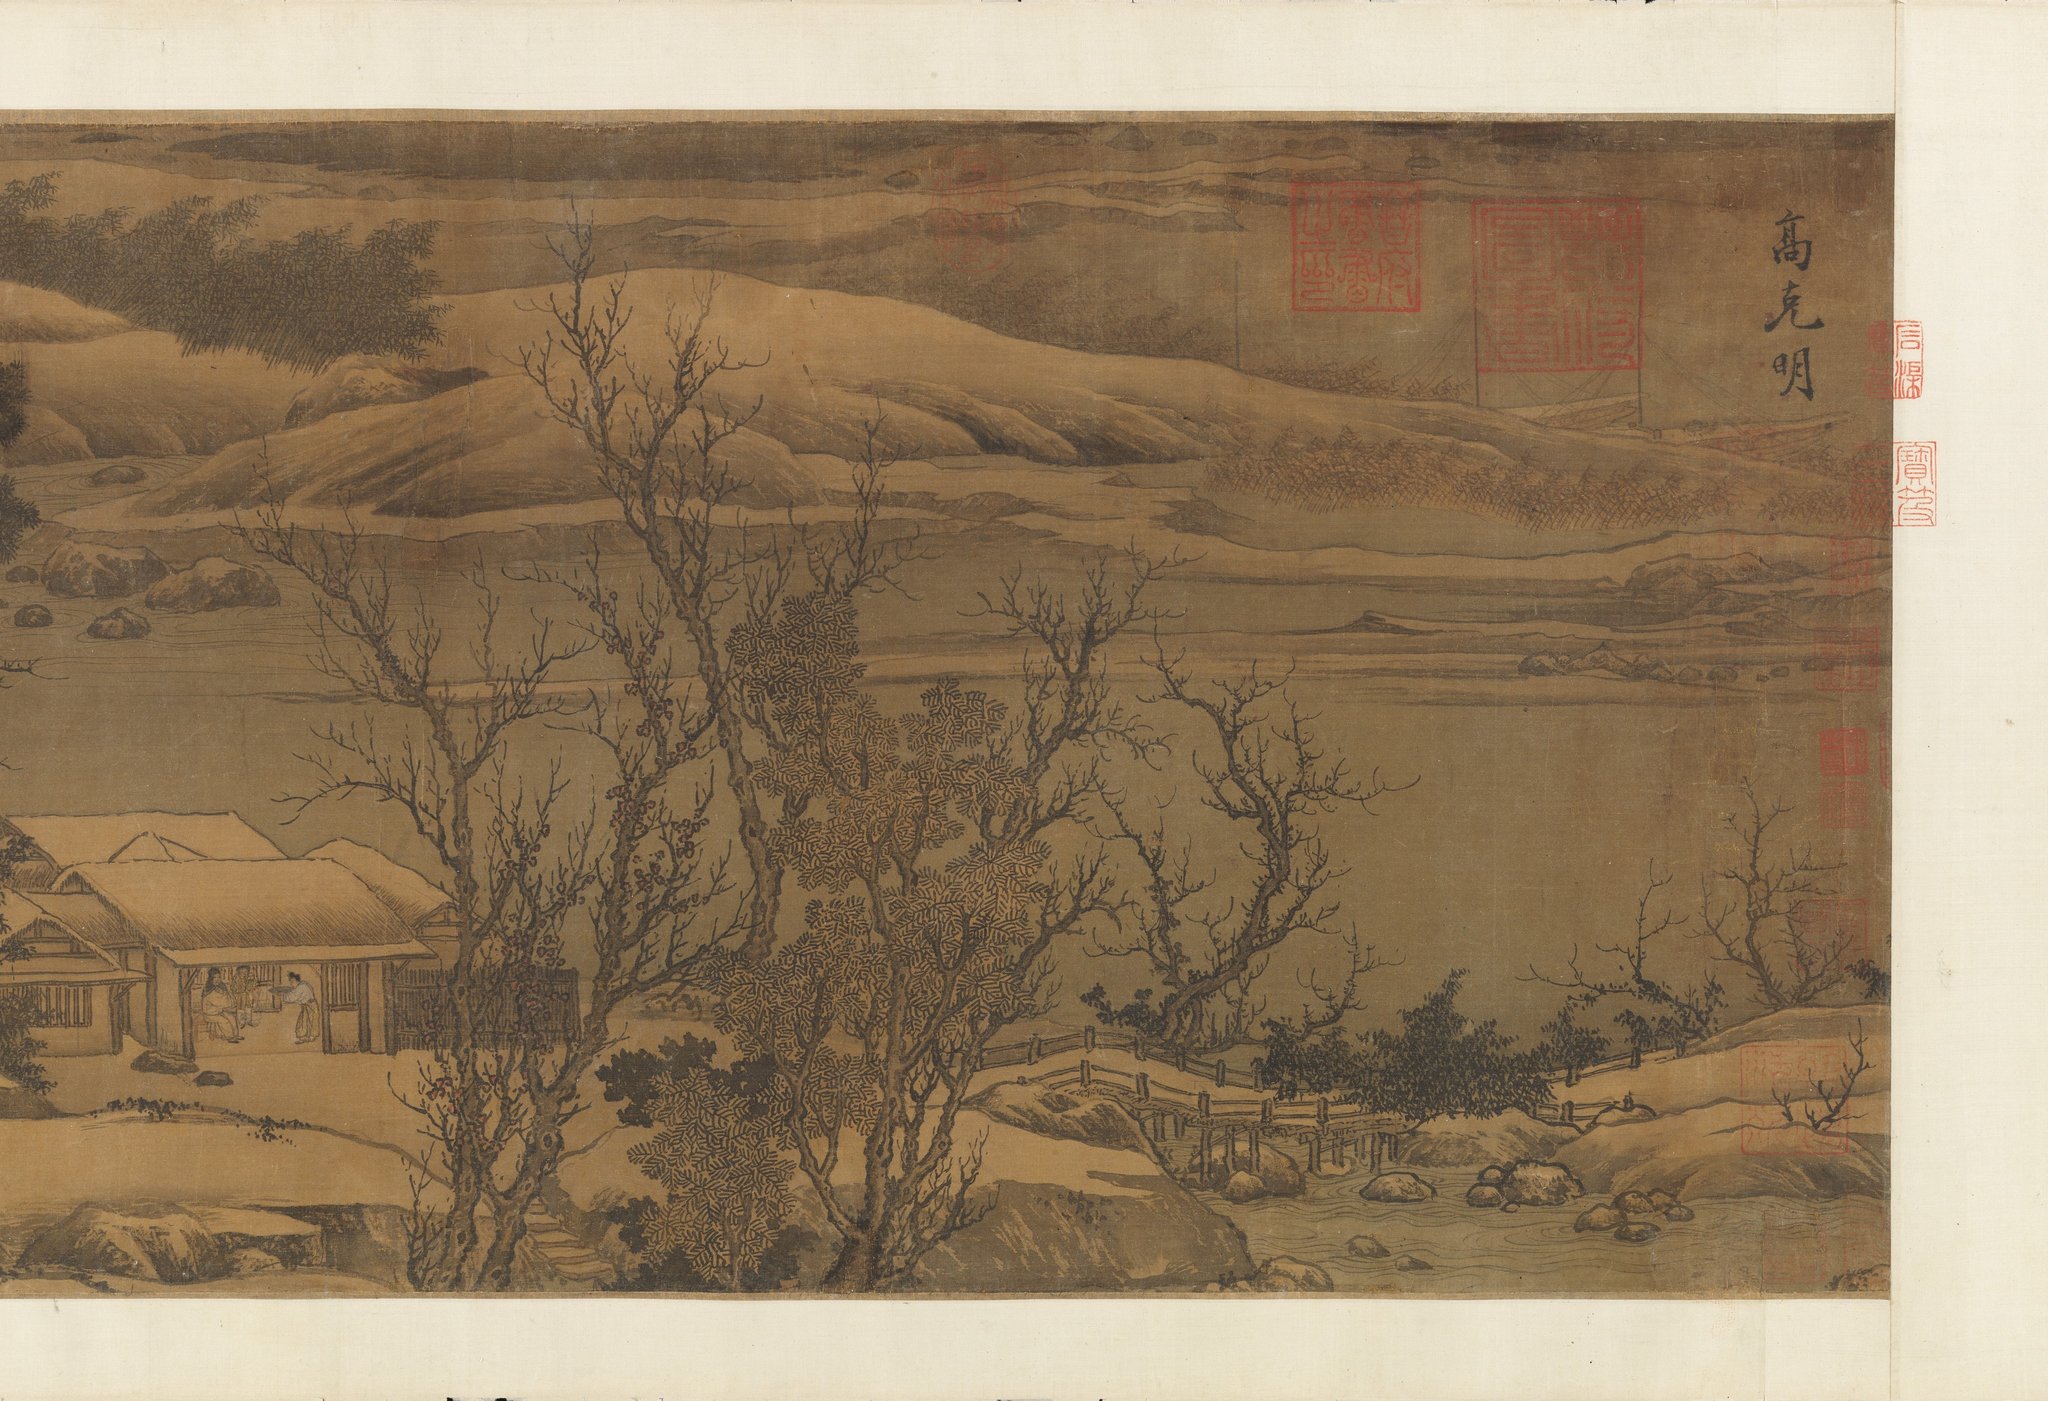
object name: handscroll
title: Snowy landscape with rustic riverside retreat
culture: chinese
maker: liu songnian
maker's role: artist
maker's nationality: chinese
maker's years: 1175-1195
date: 1167-1200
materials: ink, silk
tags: bridges,rivers,trees